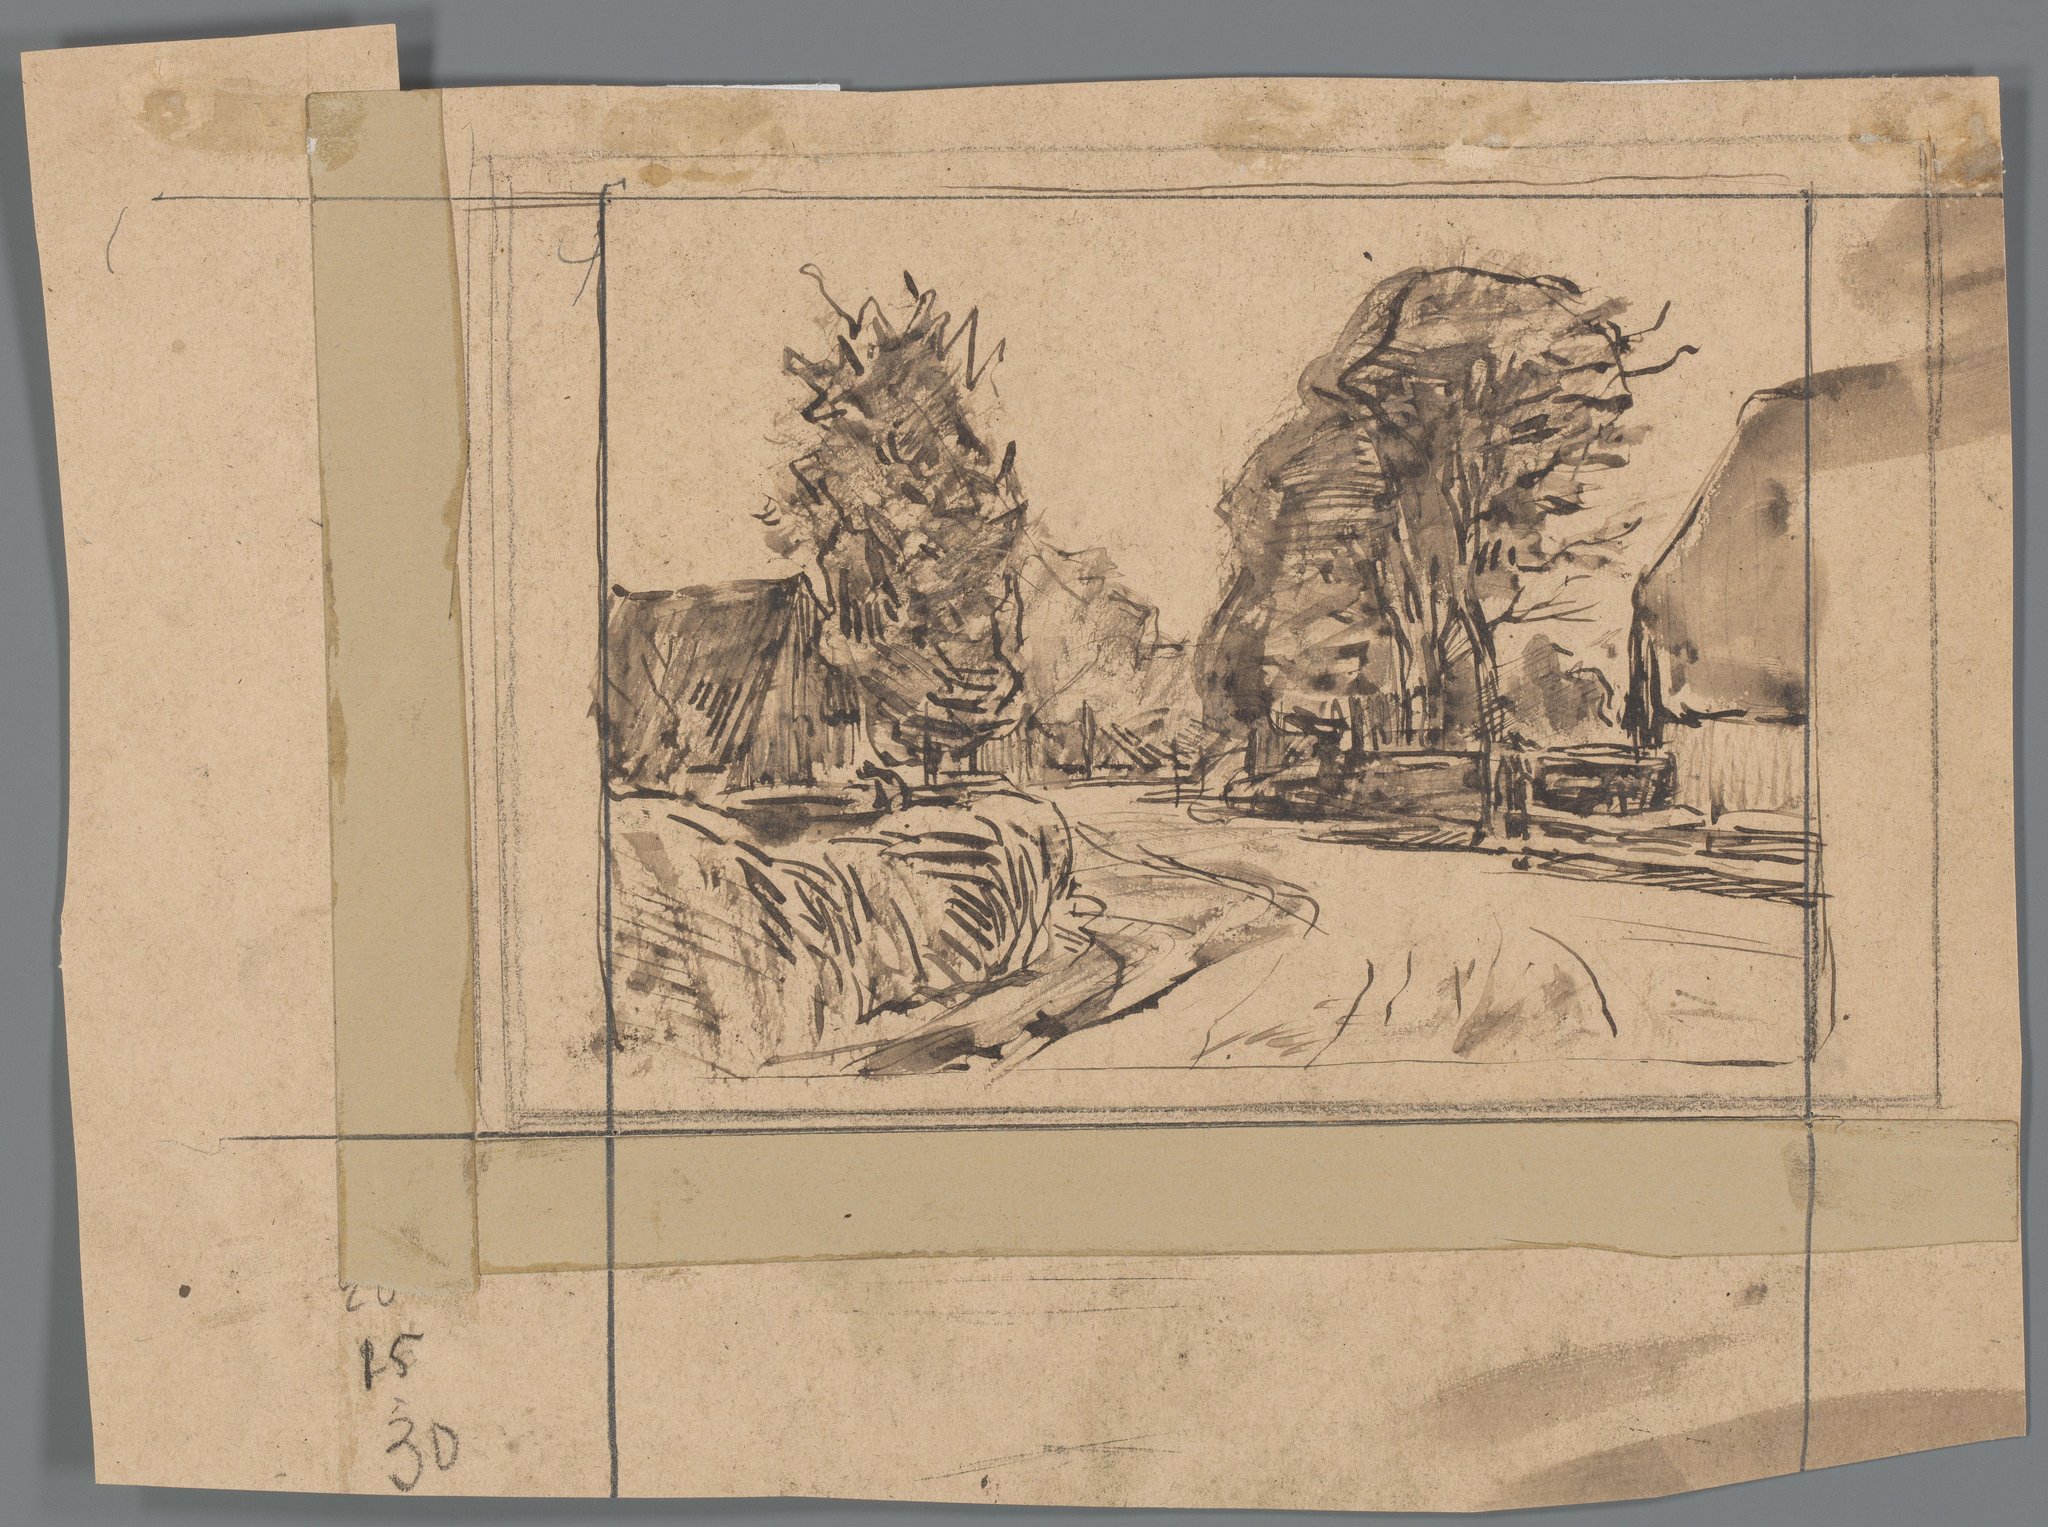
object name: drawing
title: Dorpsweg met bomen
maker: jan veth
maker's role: designer, draughtsman, painter, print maker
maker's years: 1864-1925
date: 1874-1925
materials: ink, paper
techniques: brush, pen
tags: prospect of village, silhouette of village